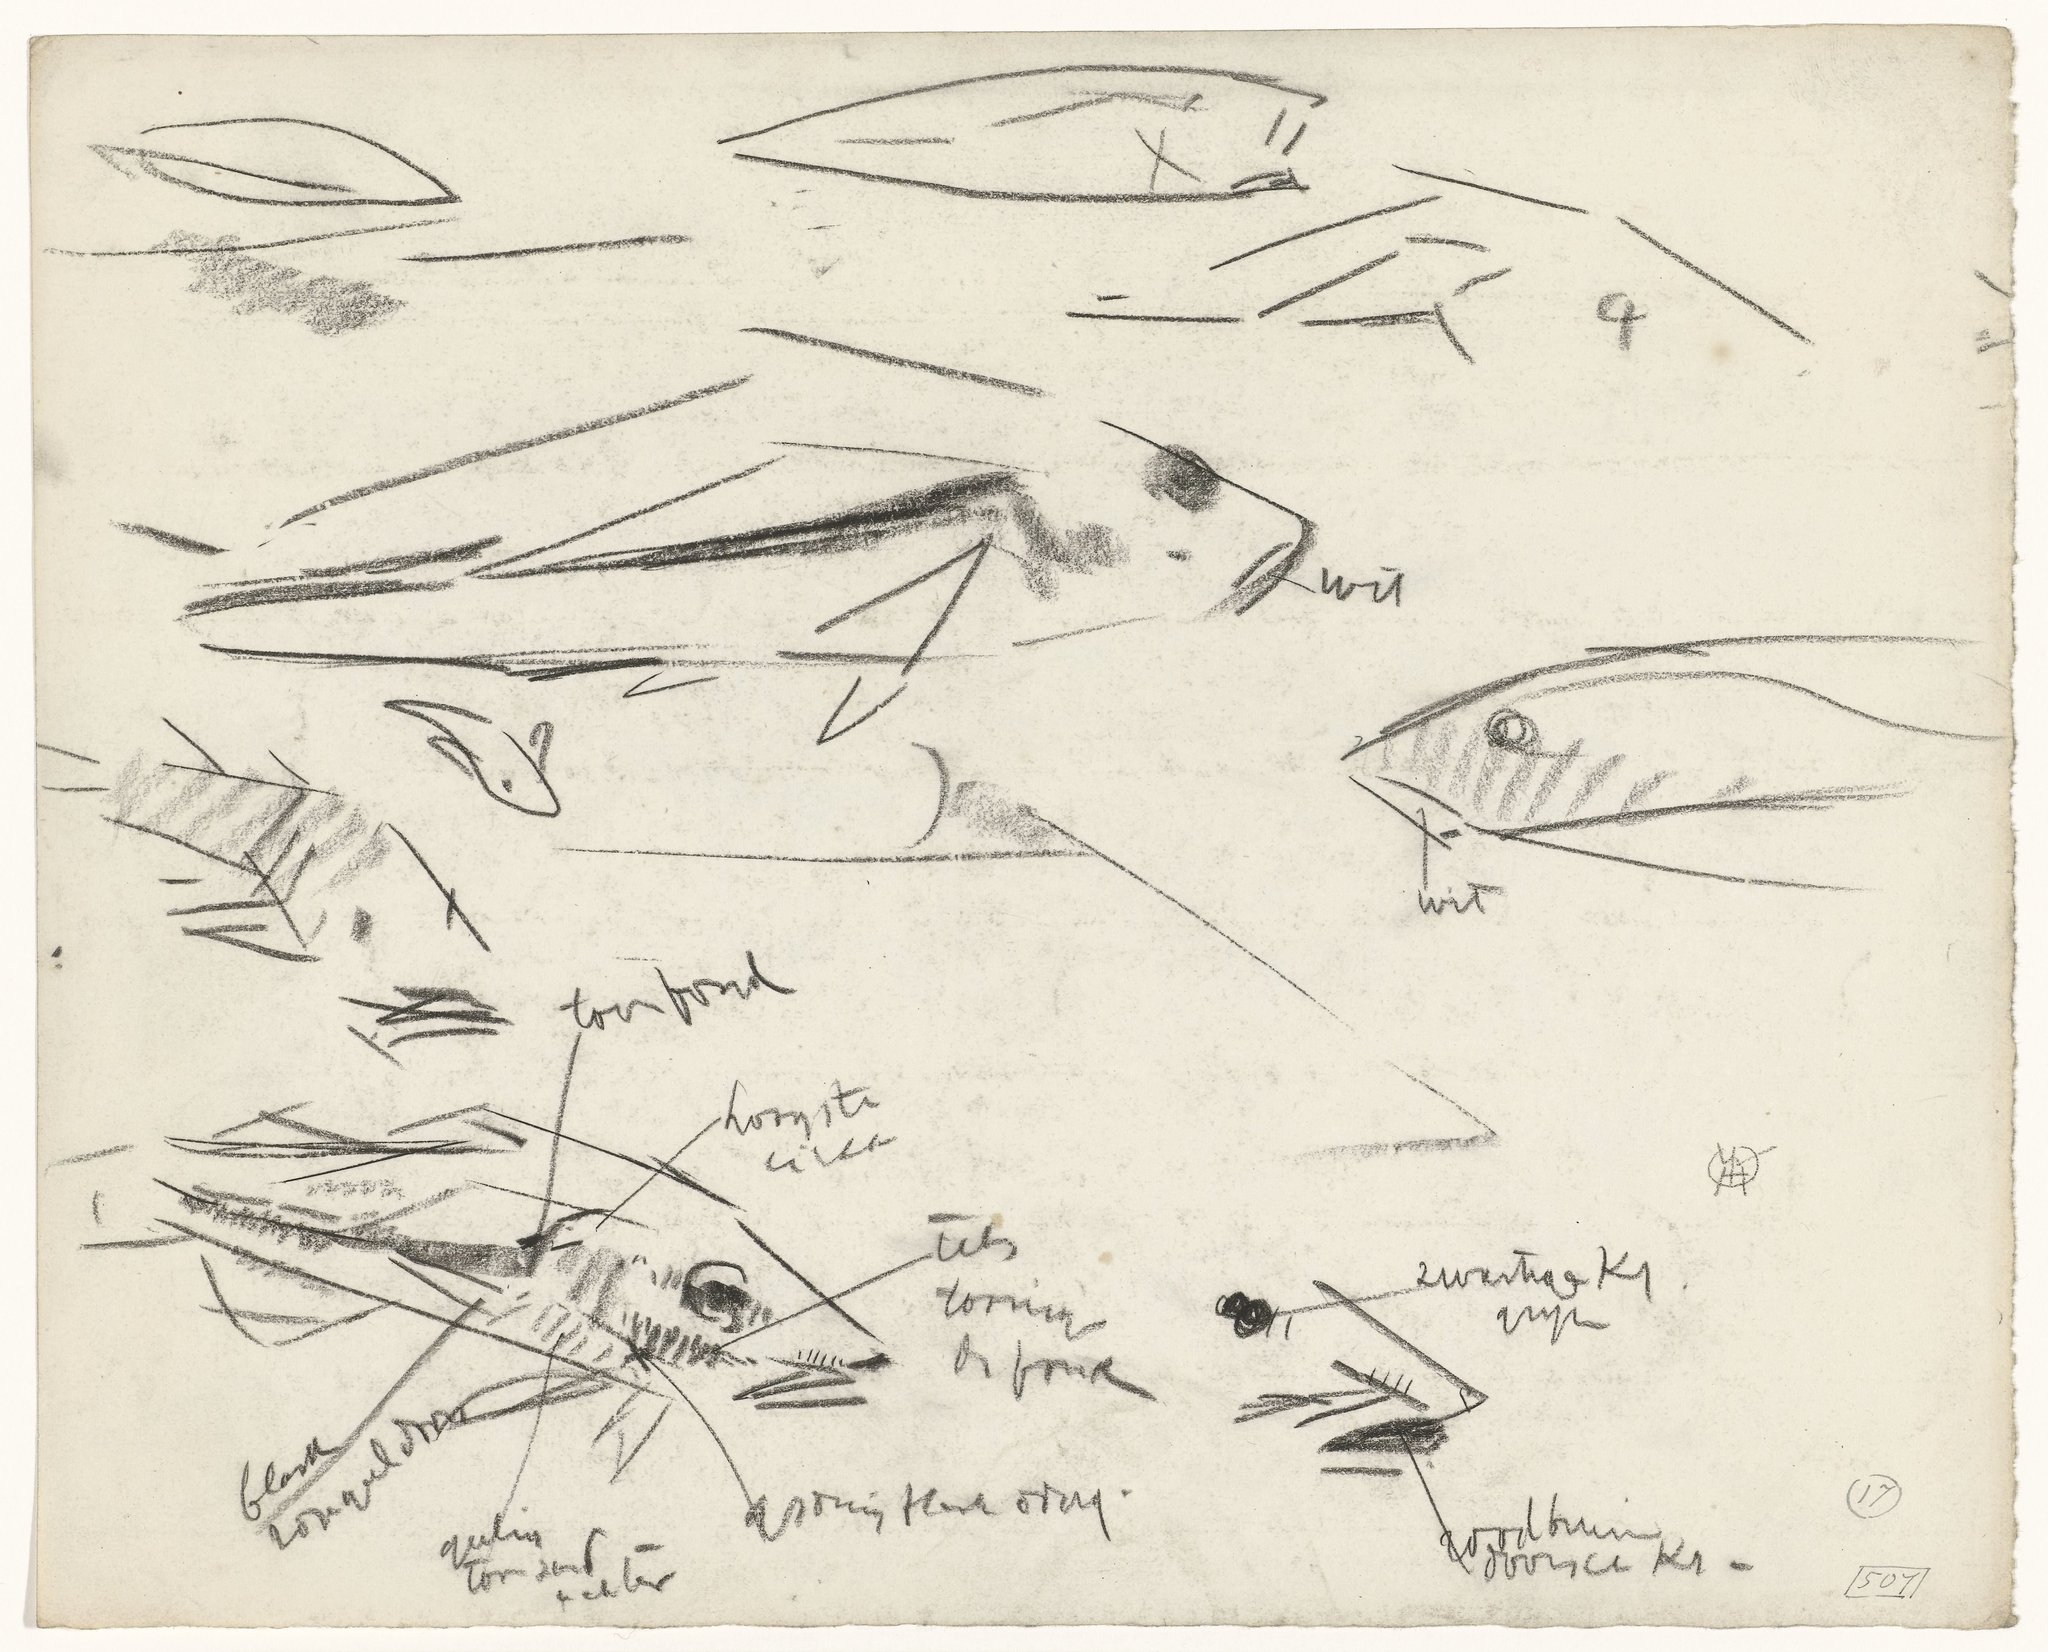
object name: drawing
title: Studies van vissen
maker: gerrit willem dijsselhof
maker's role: designer, draughtsman, print maker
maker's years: 1866-1924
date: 1876-1924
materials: chalk, paper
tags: fishes